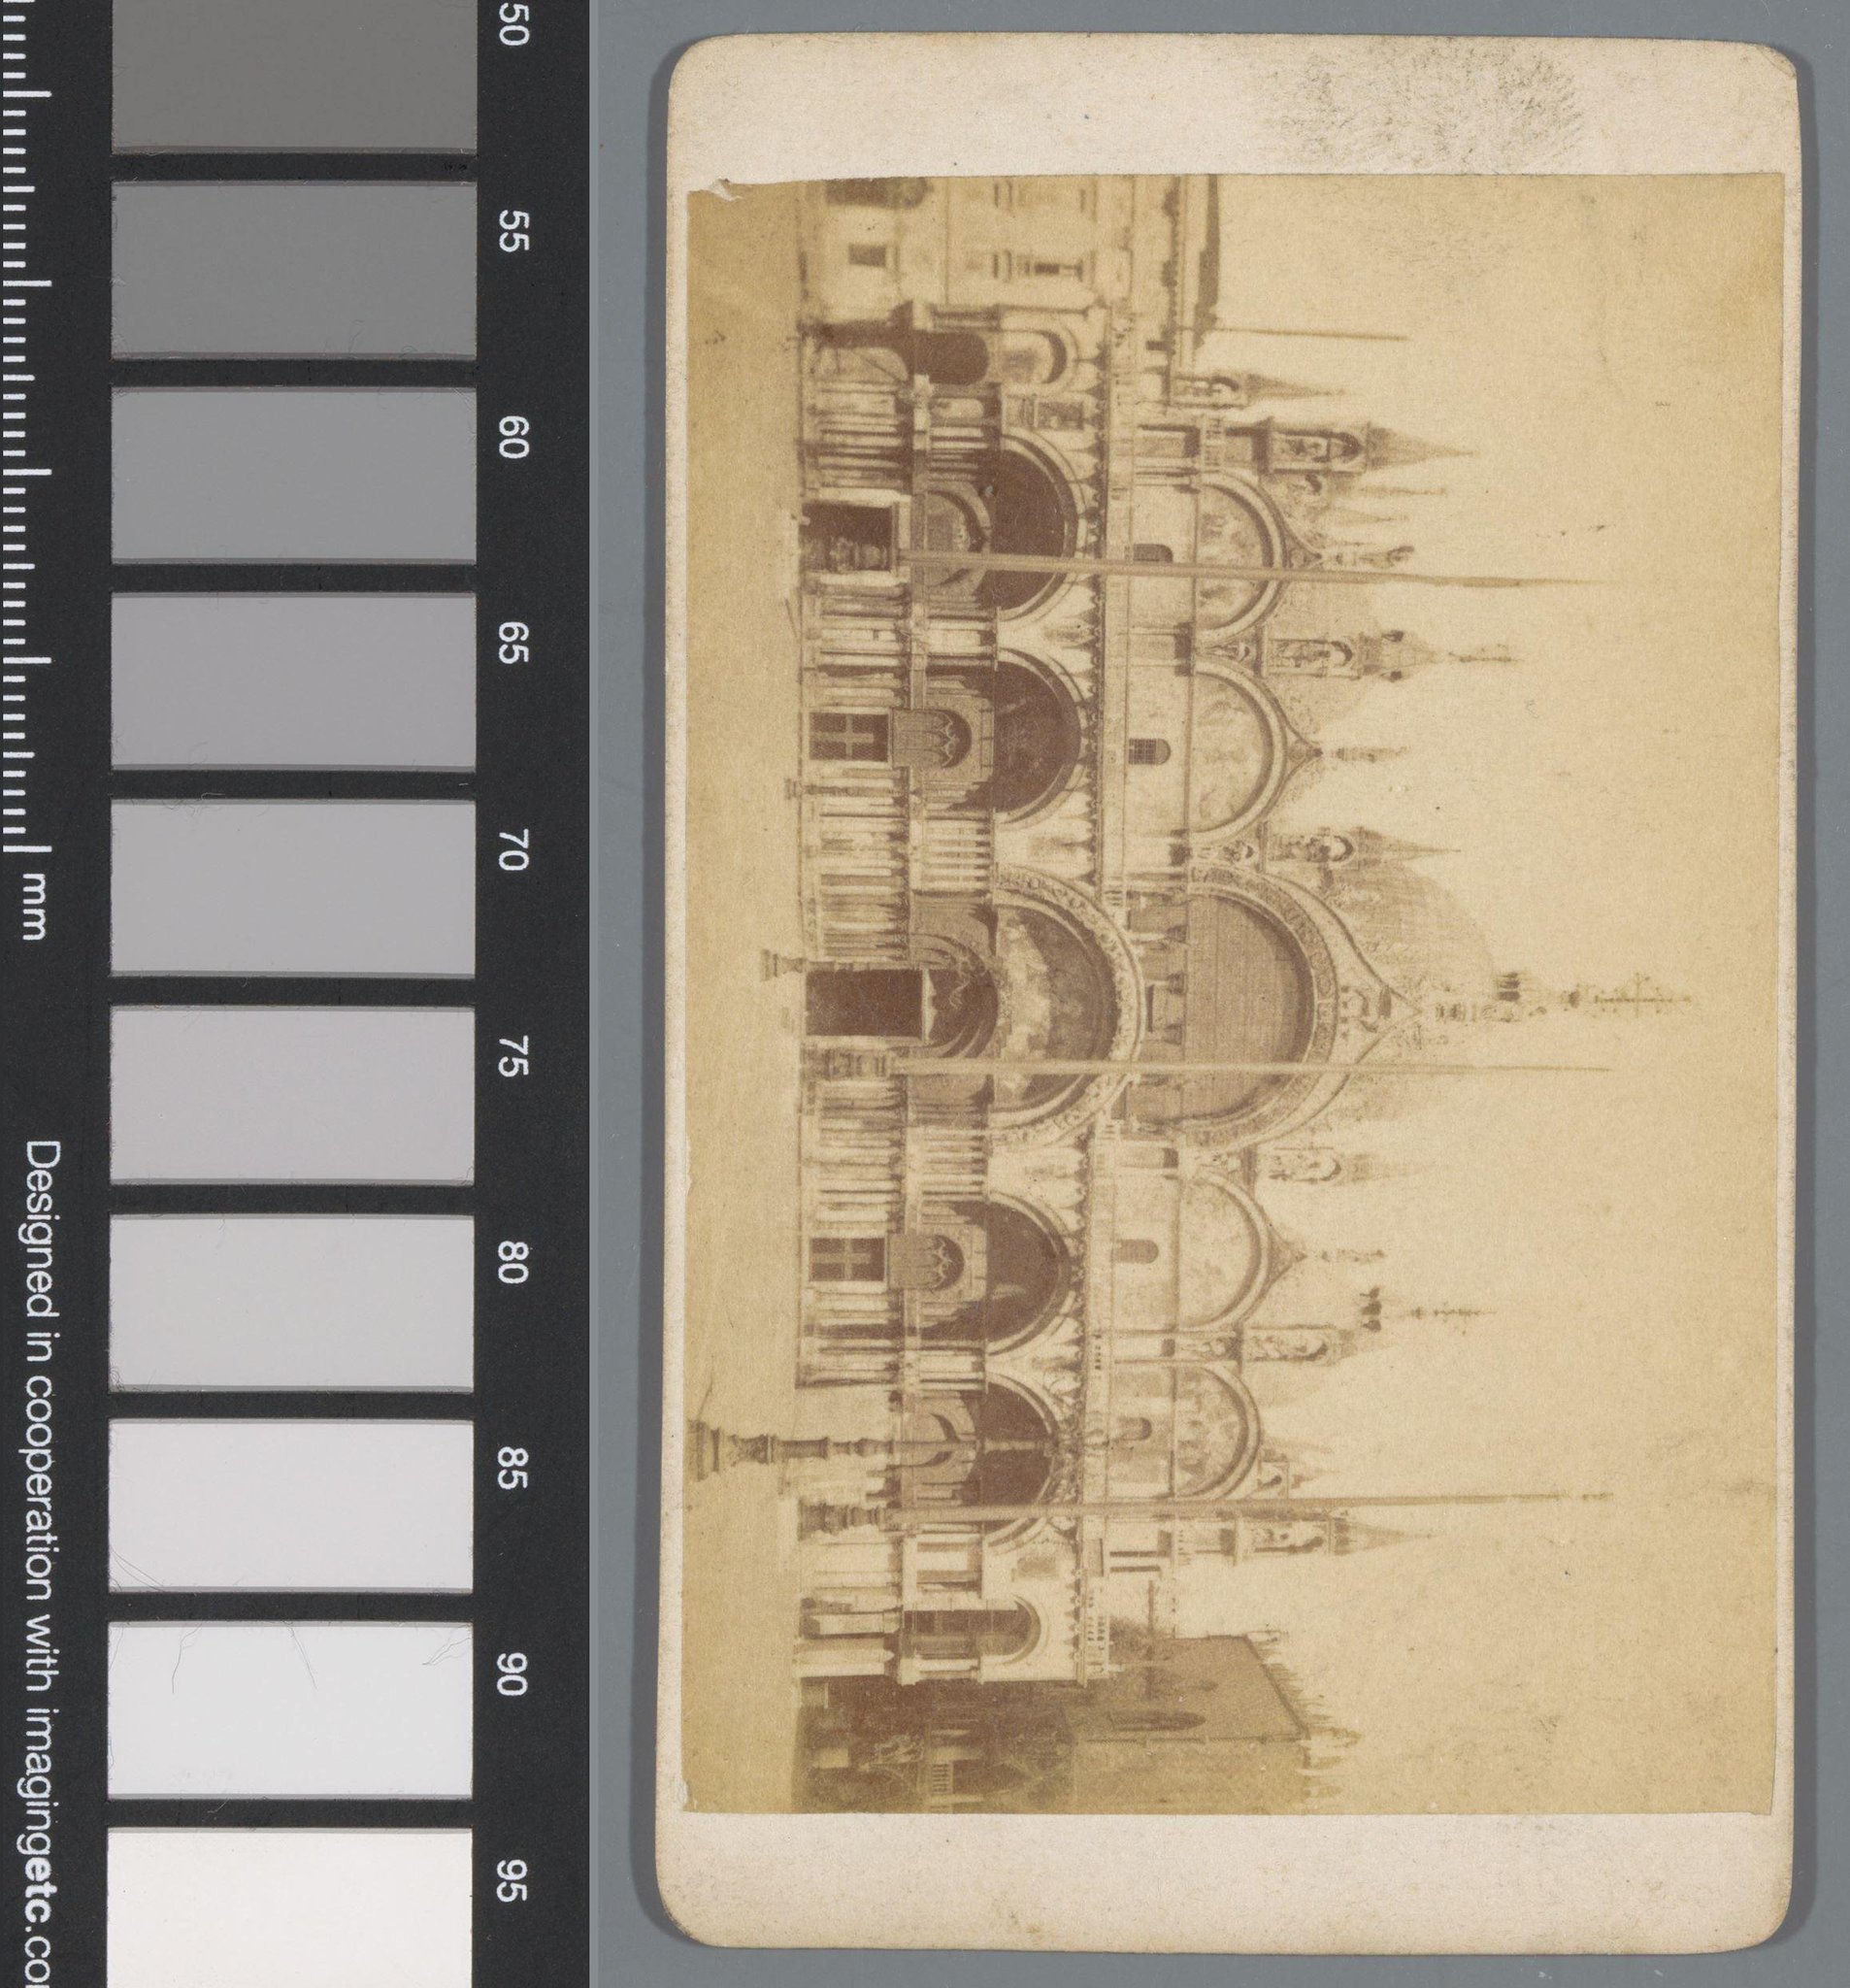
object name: photograph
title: St. Marco Venetië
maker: Anonymous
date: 1855-1885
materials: cardboard, paper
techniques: albumen print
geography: venice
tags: parts of church exterior and annexes: façade